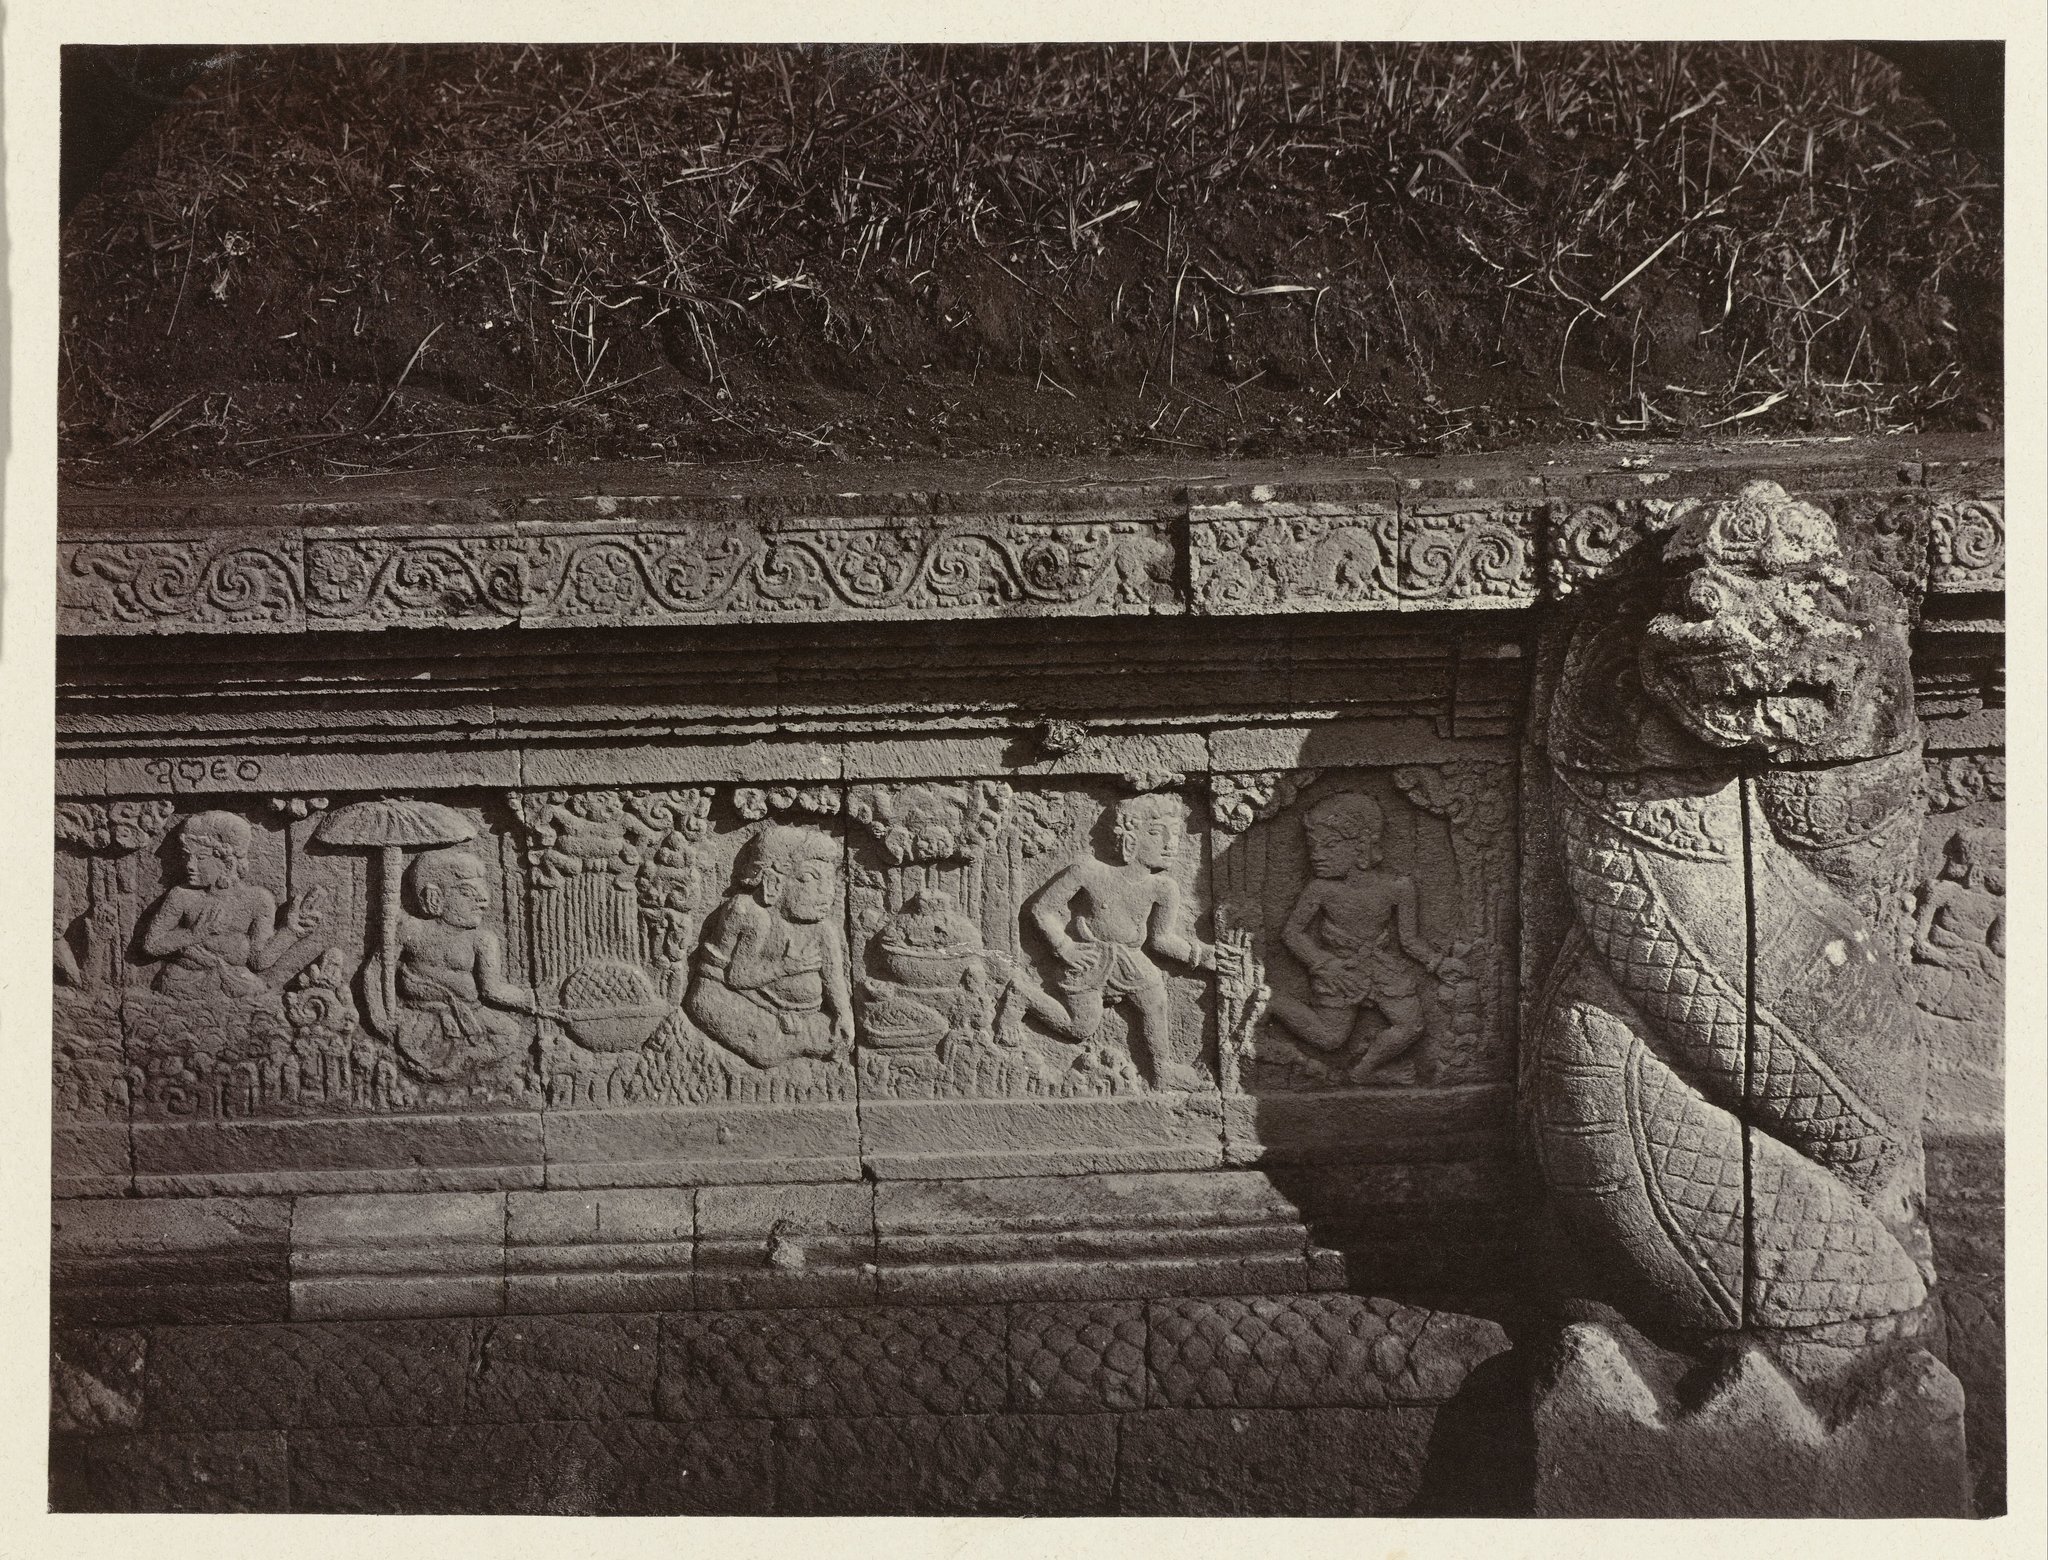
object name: photograph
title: Basrelief op het voetstuk eener pendopo (?) (Oostzijde). Panataran (r. Kediri)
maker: isidore kinsbergen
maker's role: fotograaf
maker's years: 1821-1905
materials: cardboard, paper, photographic support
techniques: albumen print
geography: java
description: Candi Panataran (Temple Complex), Pendopo terrace, reliefs 10-13 ('Sang Satyawan' story; inscription above no 10 reads ibu jawa) and entwined naga, east side. Panataran, Blitar district, East Java province 1375 AD.